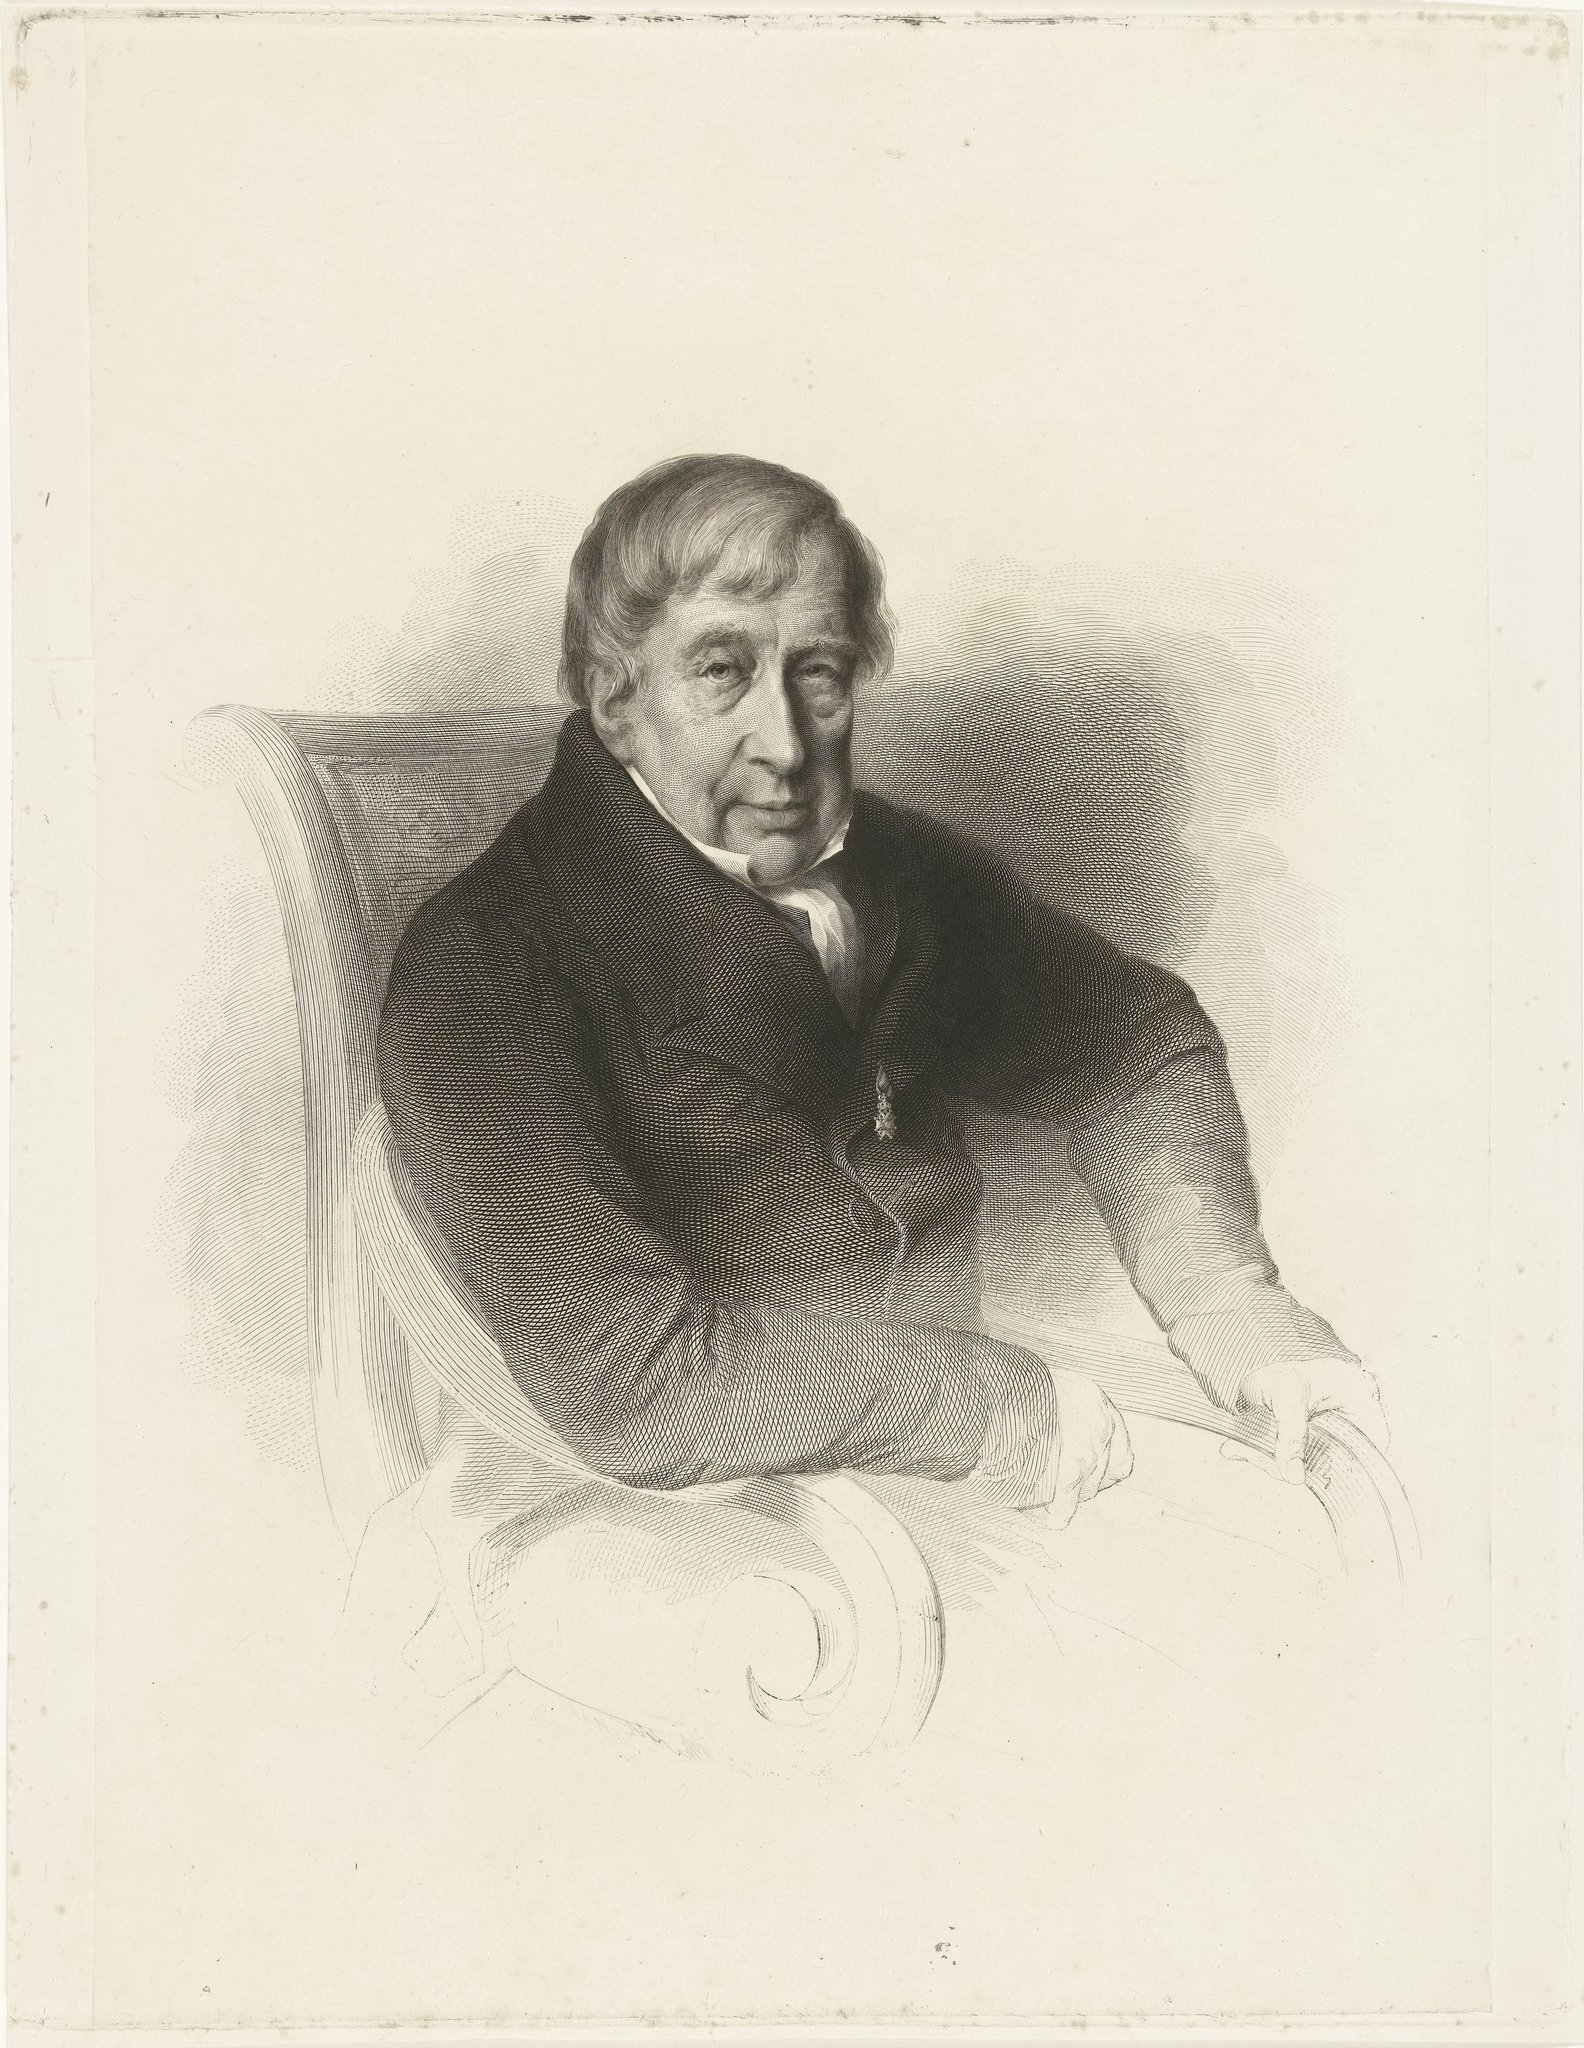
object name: print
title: Portret van de arts Herman Haakman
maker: henricus wilhelmus couwenberg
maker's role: draughtsman, print maker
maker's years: 1814-1845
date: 1829-1840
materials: paper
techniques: engraving, roulette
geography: amsterdam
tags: physician, doctor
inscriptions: collector's mark: Lugt 2228